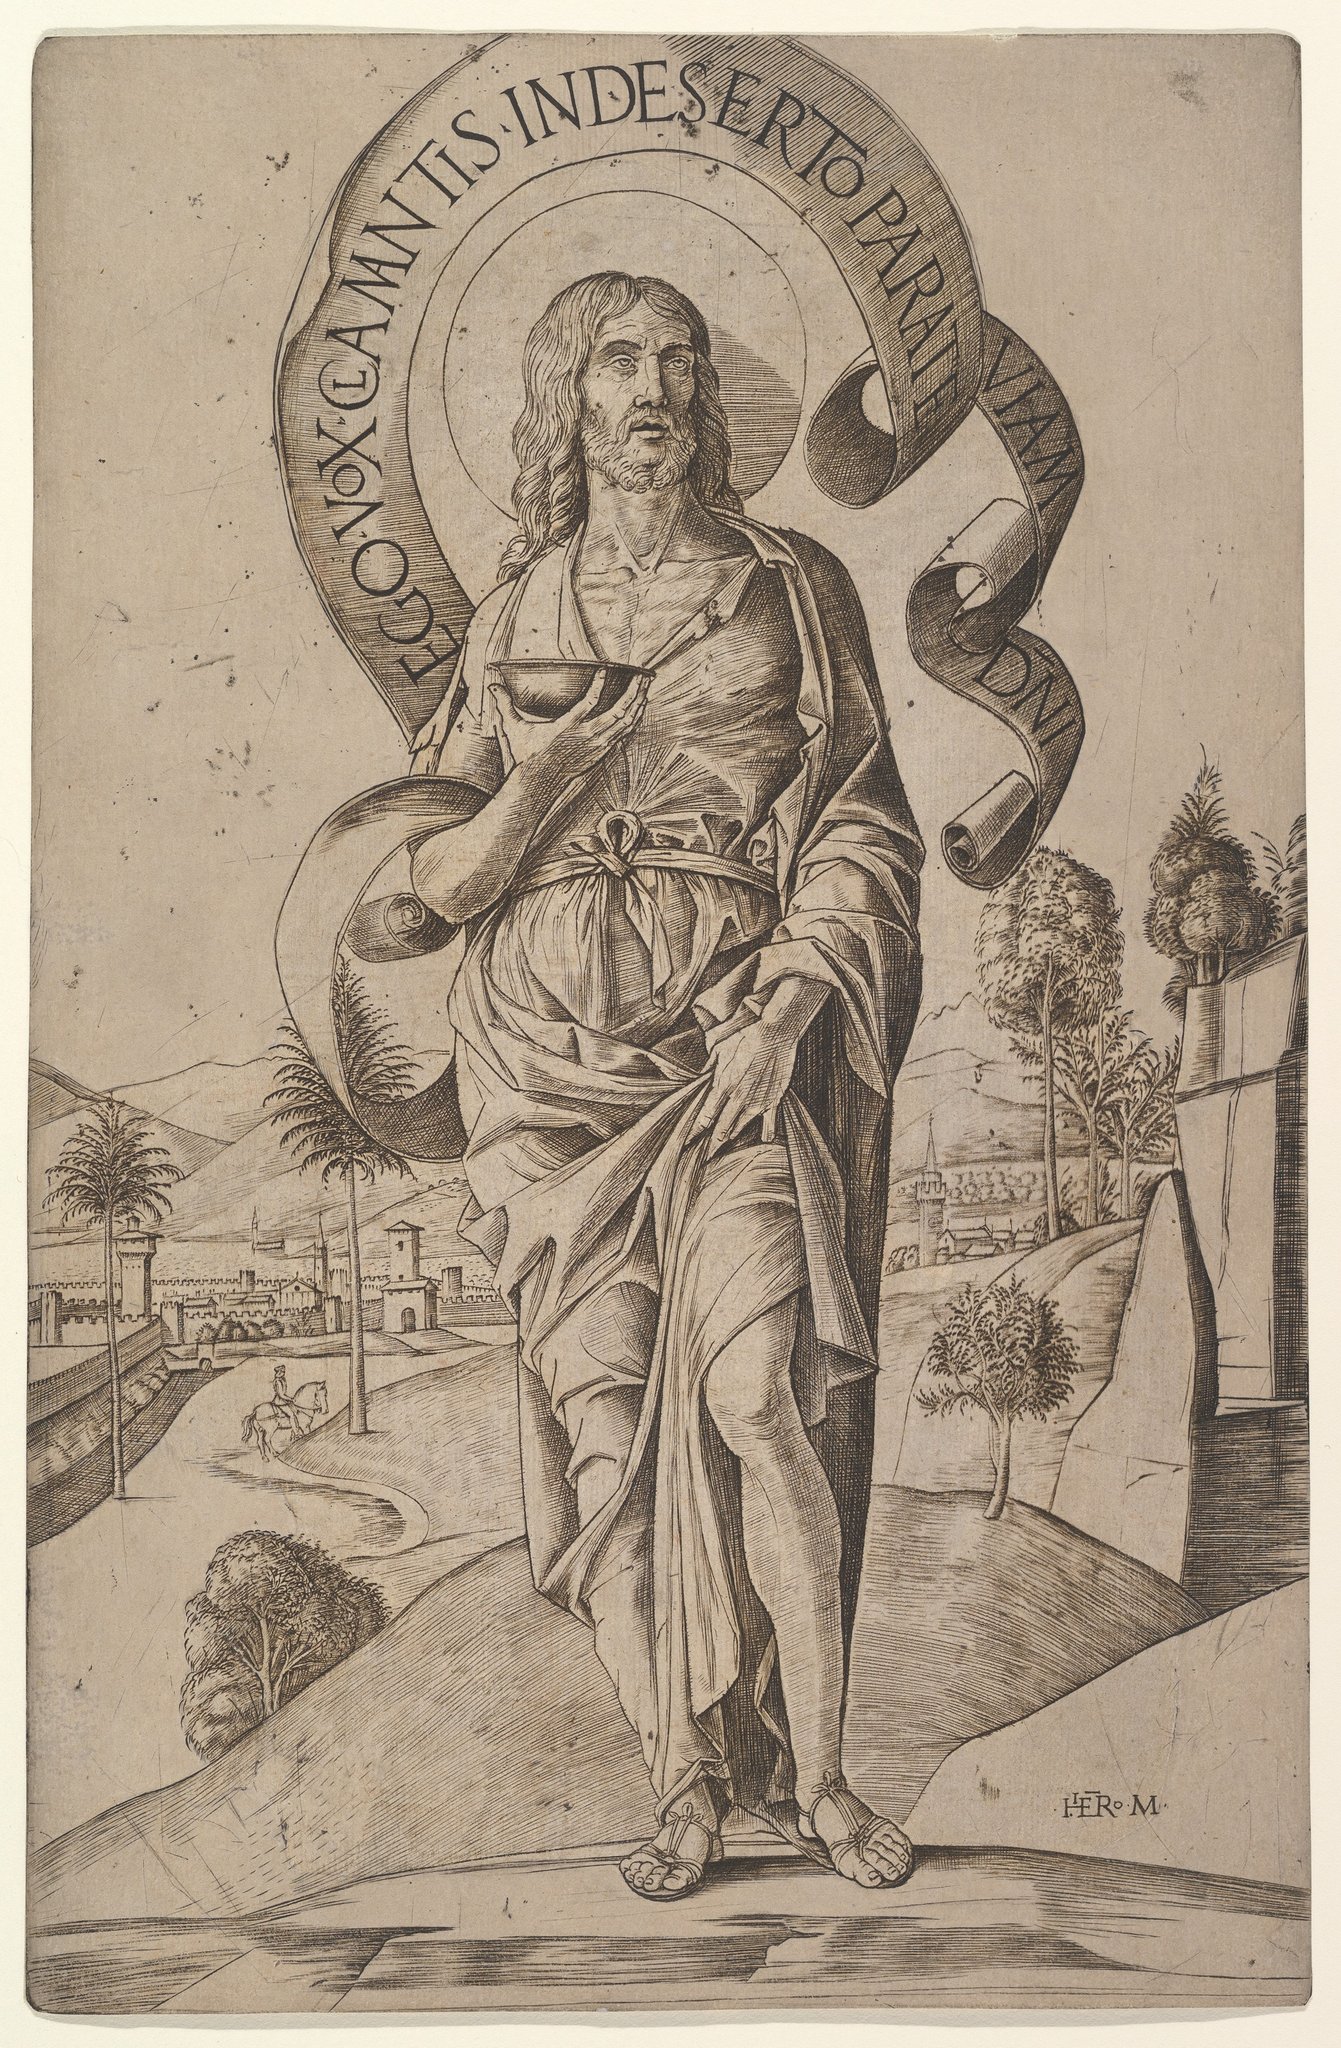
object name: print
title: Saint John the Baptist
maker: girolamo mocetto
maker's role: artist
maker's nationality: italian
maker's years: 1470-1531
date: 1500-1506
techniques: engraving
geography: venice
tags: saint john the baptist